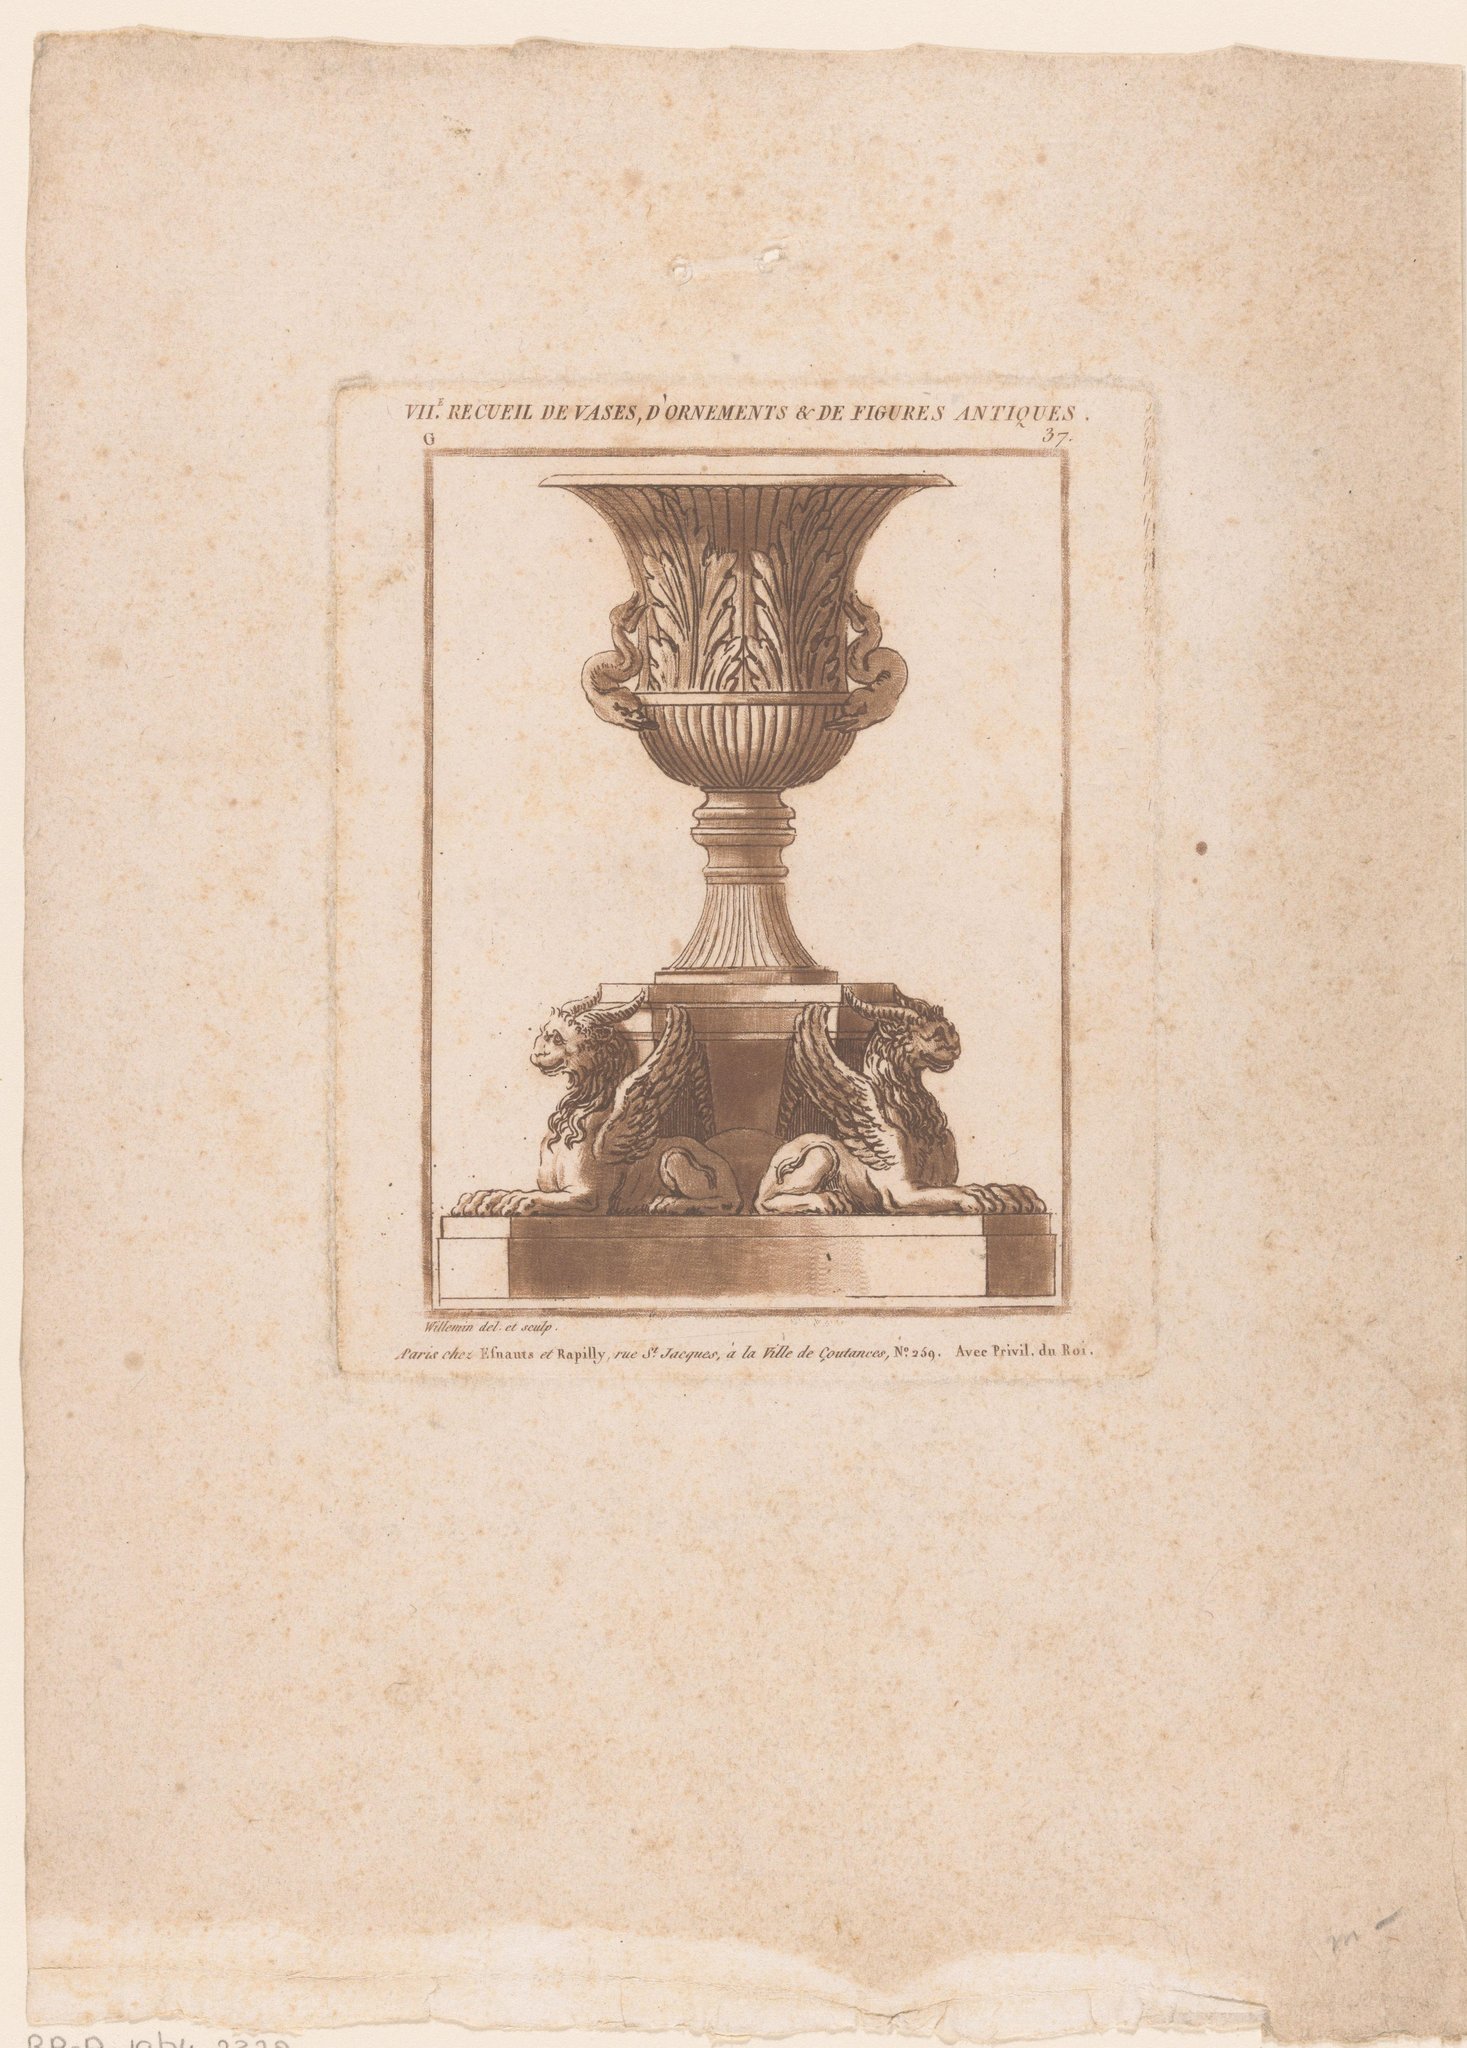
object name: print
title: G VIIe Recueil De Vases, D'Ornements & De Figures Antiques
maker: nicolas xavier willemin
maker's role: print maker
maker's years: 1763-1839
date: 1775-1797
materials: paper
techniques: aquatint, etching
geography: paris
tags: griffin (lion/eagle); 'griffo' (ripa), vase ~ ornament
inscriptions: collector's mark: Lugt 2228, collector's mark: Lugt 2760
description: Een geornamenteerde vaas met acanthusbladeren en dolfijnen. Aan de onderzijde liggen twee griffioenen.